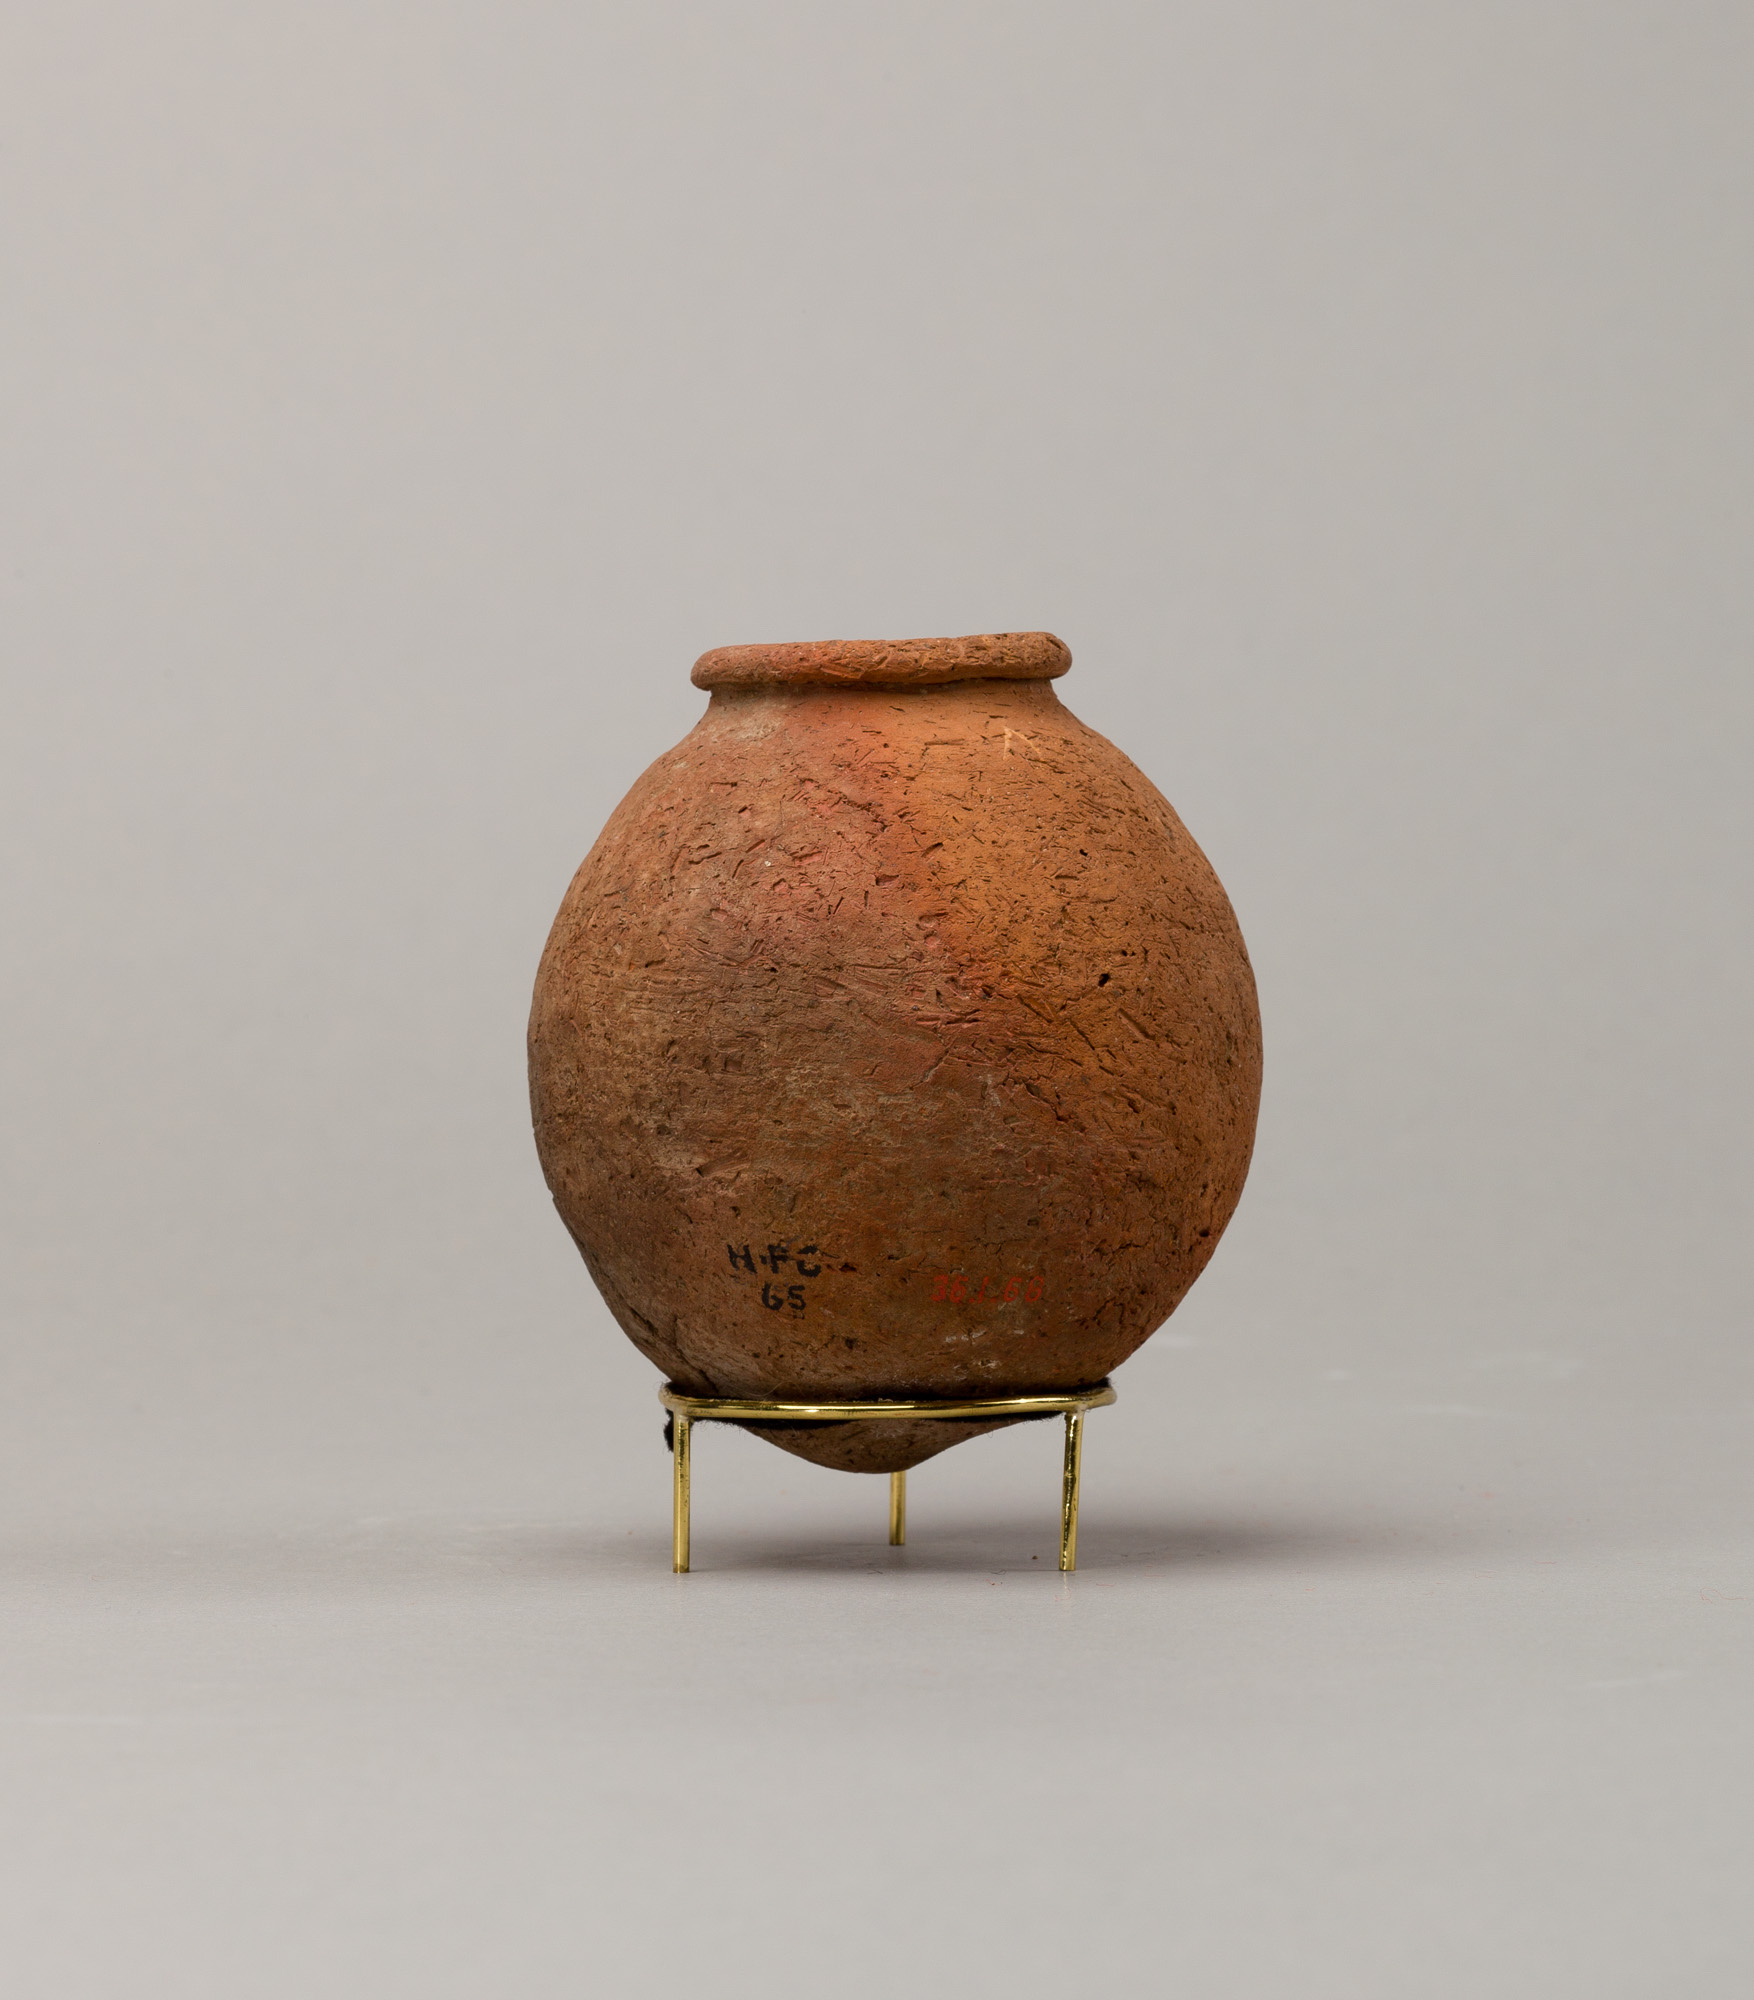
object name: jar, rough ware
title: Rough ware jar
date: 3850-2960 BCE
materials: pottery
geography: egypt